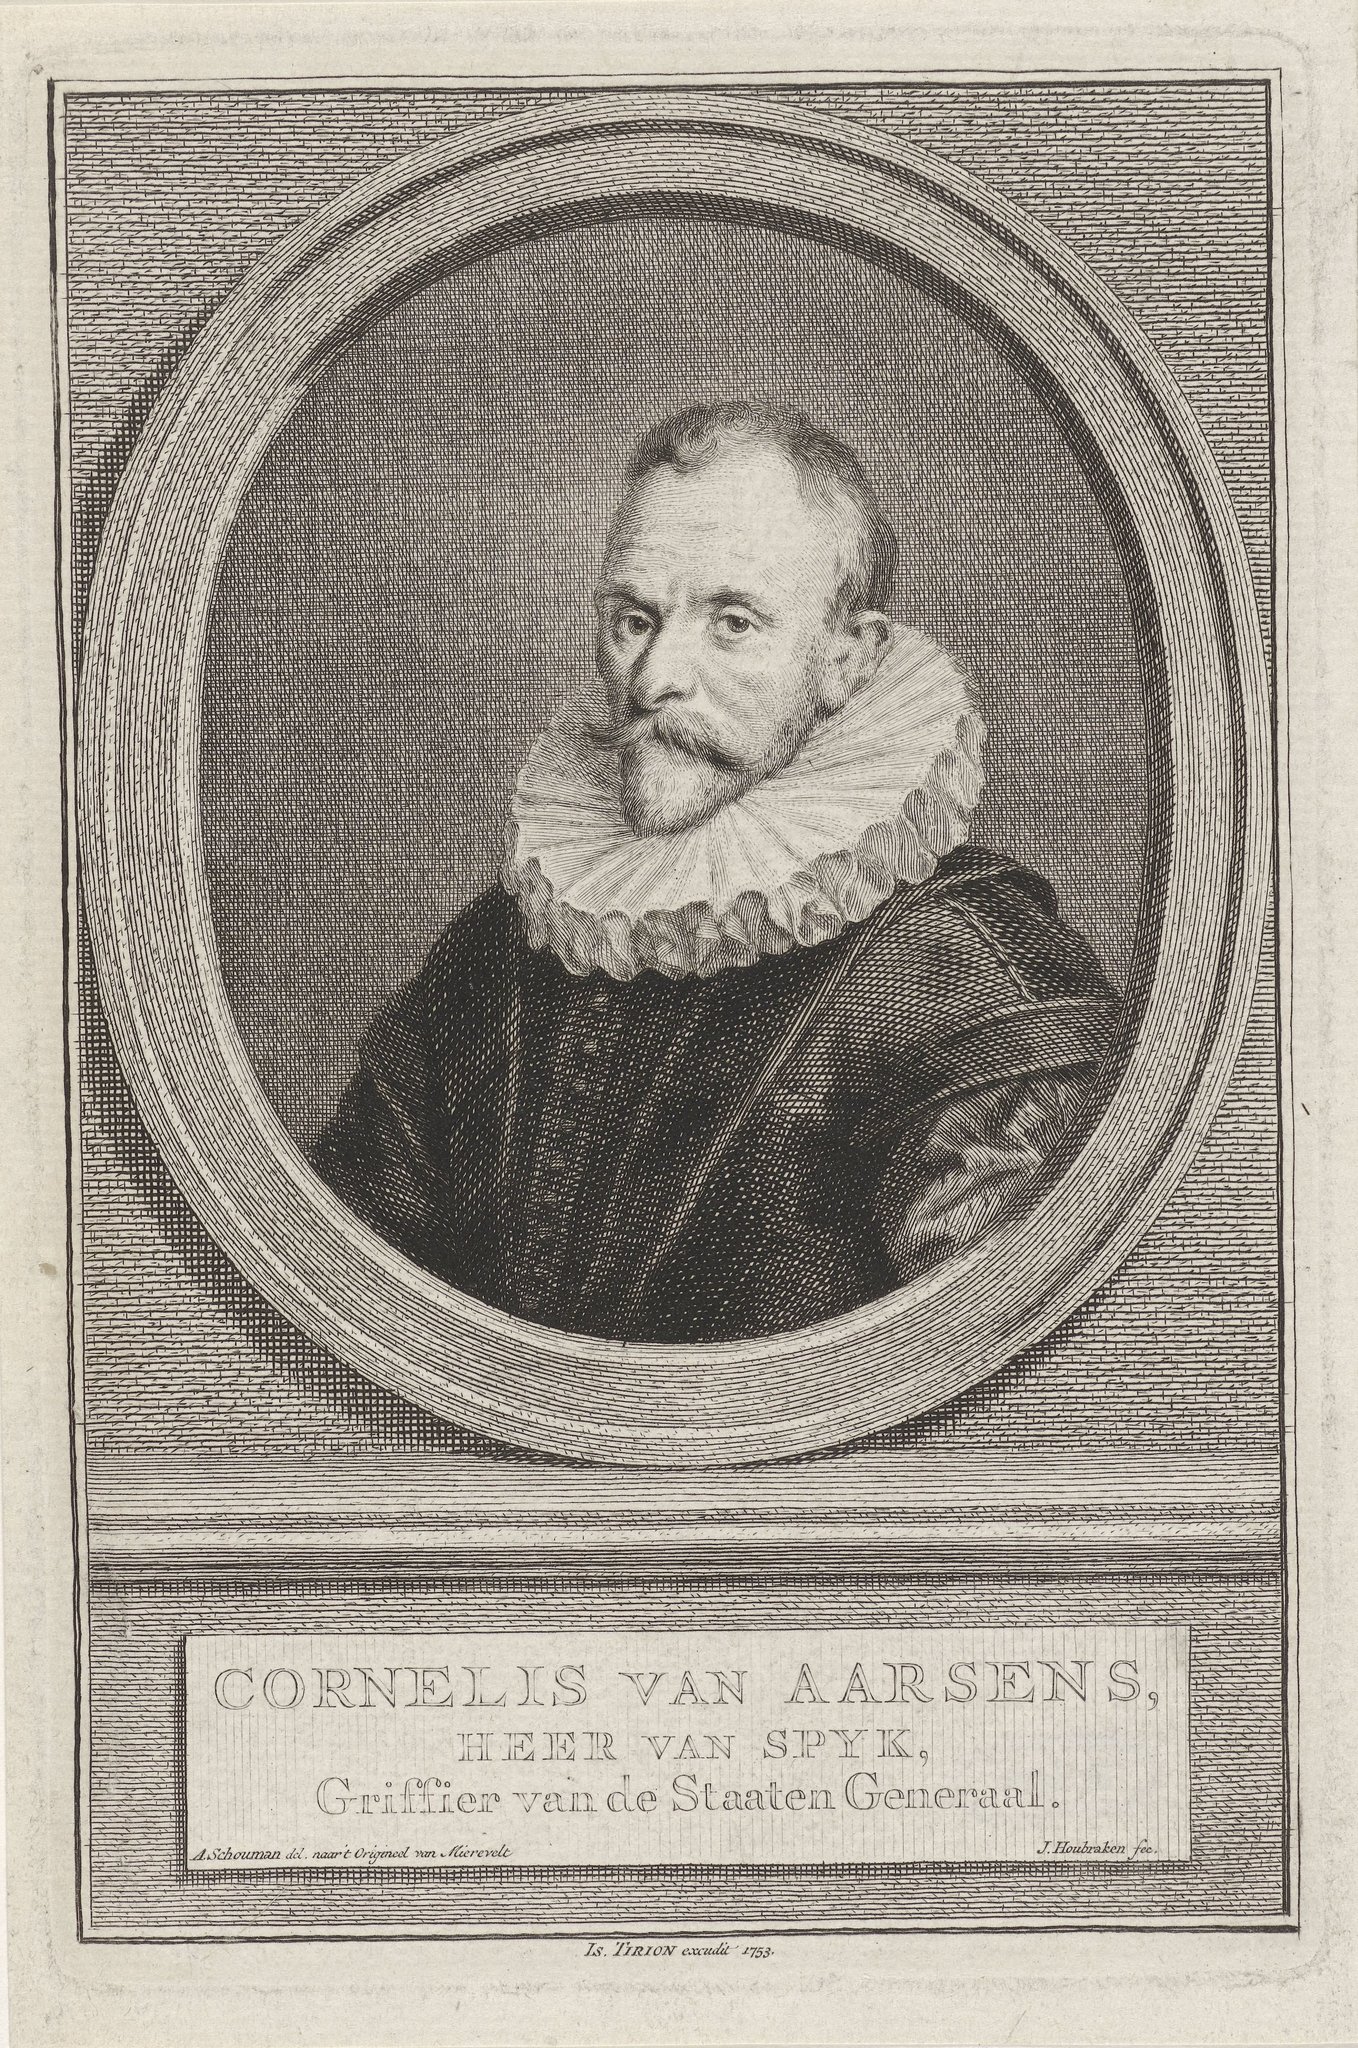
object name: print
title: Portret van Cornelis van Aersens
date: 1753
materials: paper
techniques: engraving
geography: amsterdam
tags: antwerp, the hague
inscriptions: collector's mark: Lugt 2228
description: Prent ook gebruikt in: Jan Wagenaar, Vaderlandsche historie, vervattende de geschiedenissen der nu Vereenigde Nederlanden, inzonderheid die van Holland (...), 21 delen. Amsterdam, Isaak Tirion, 1749-59.